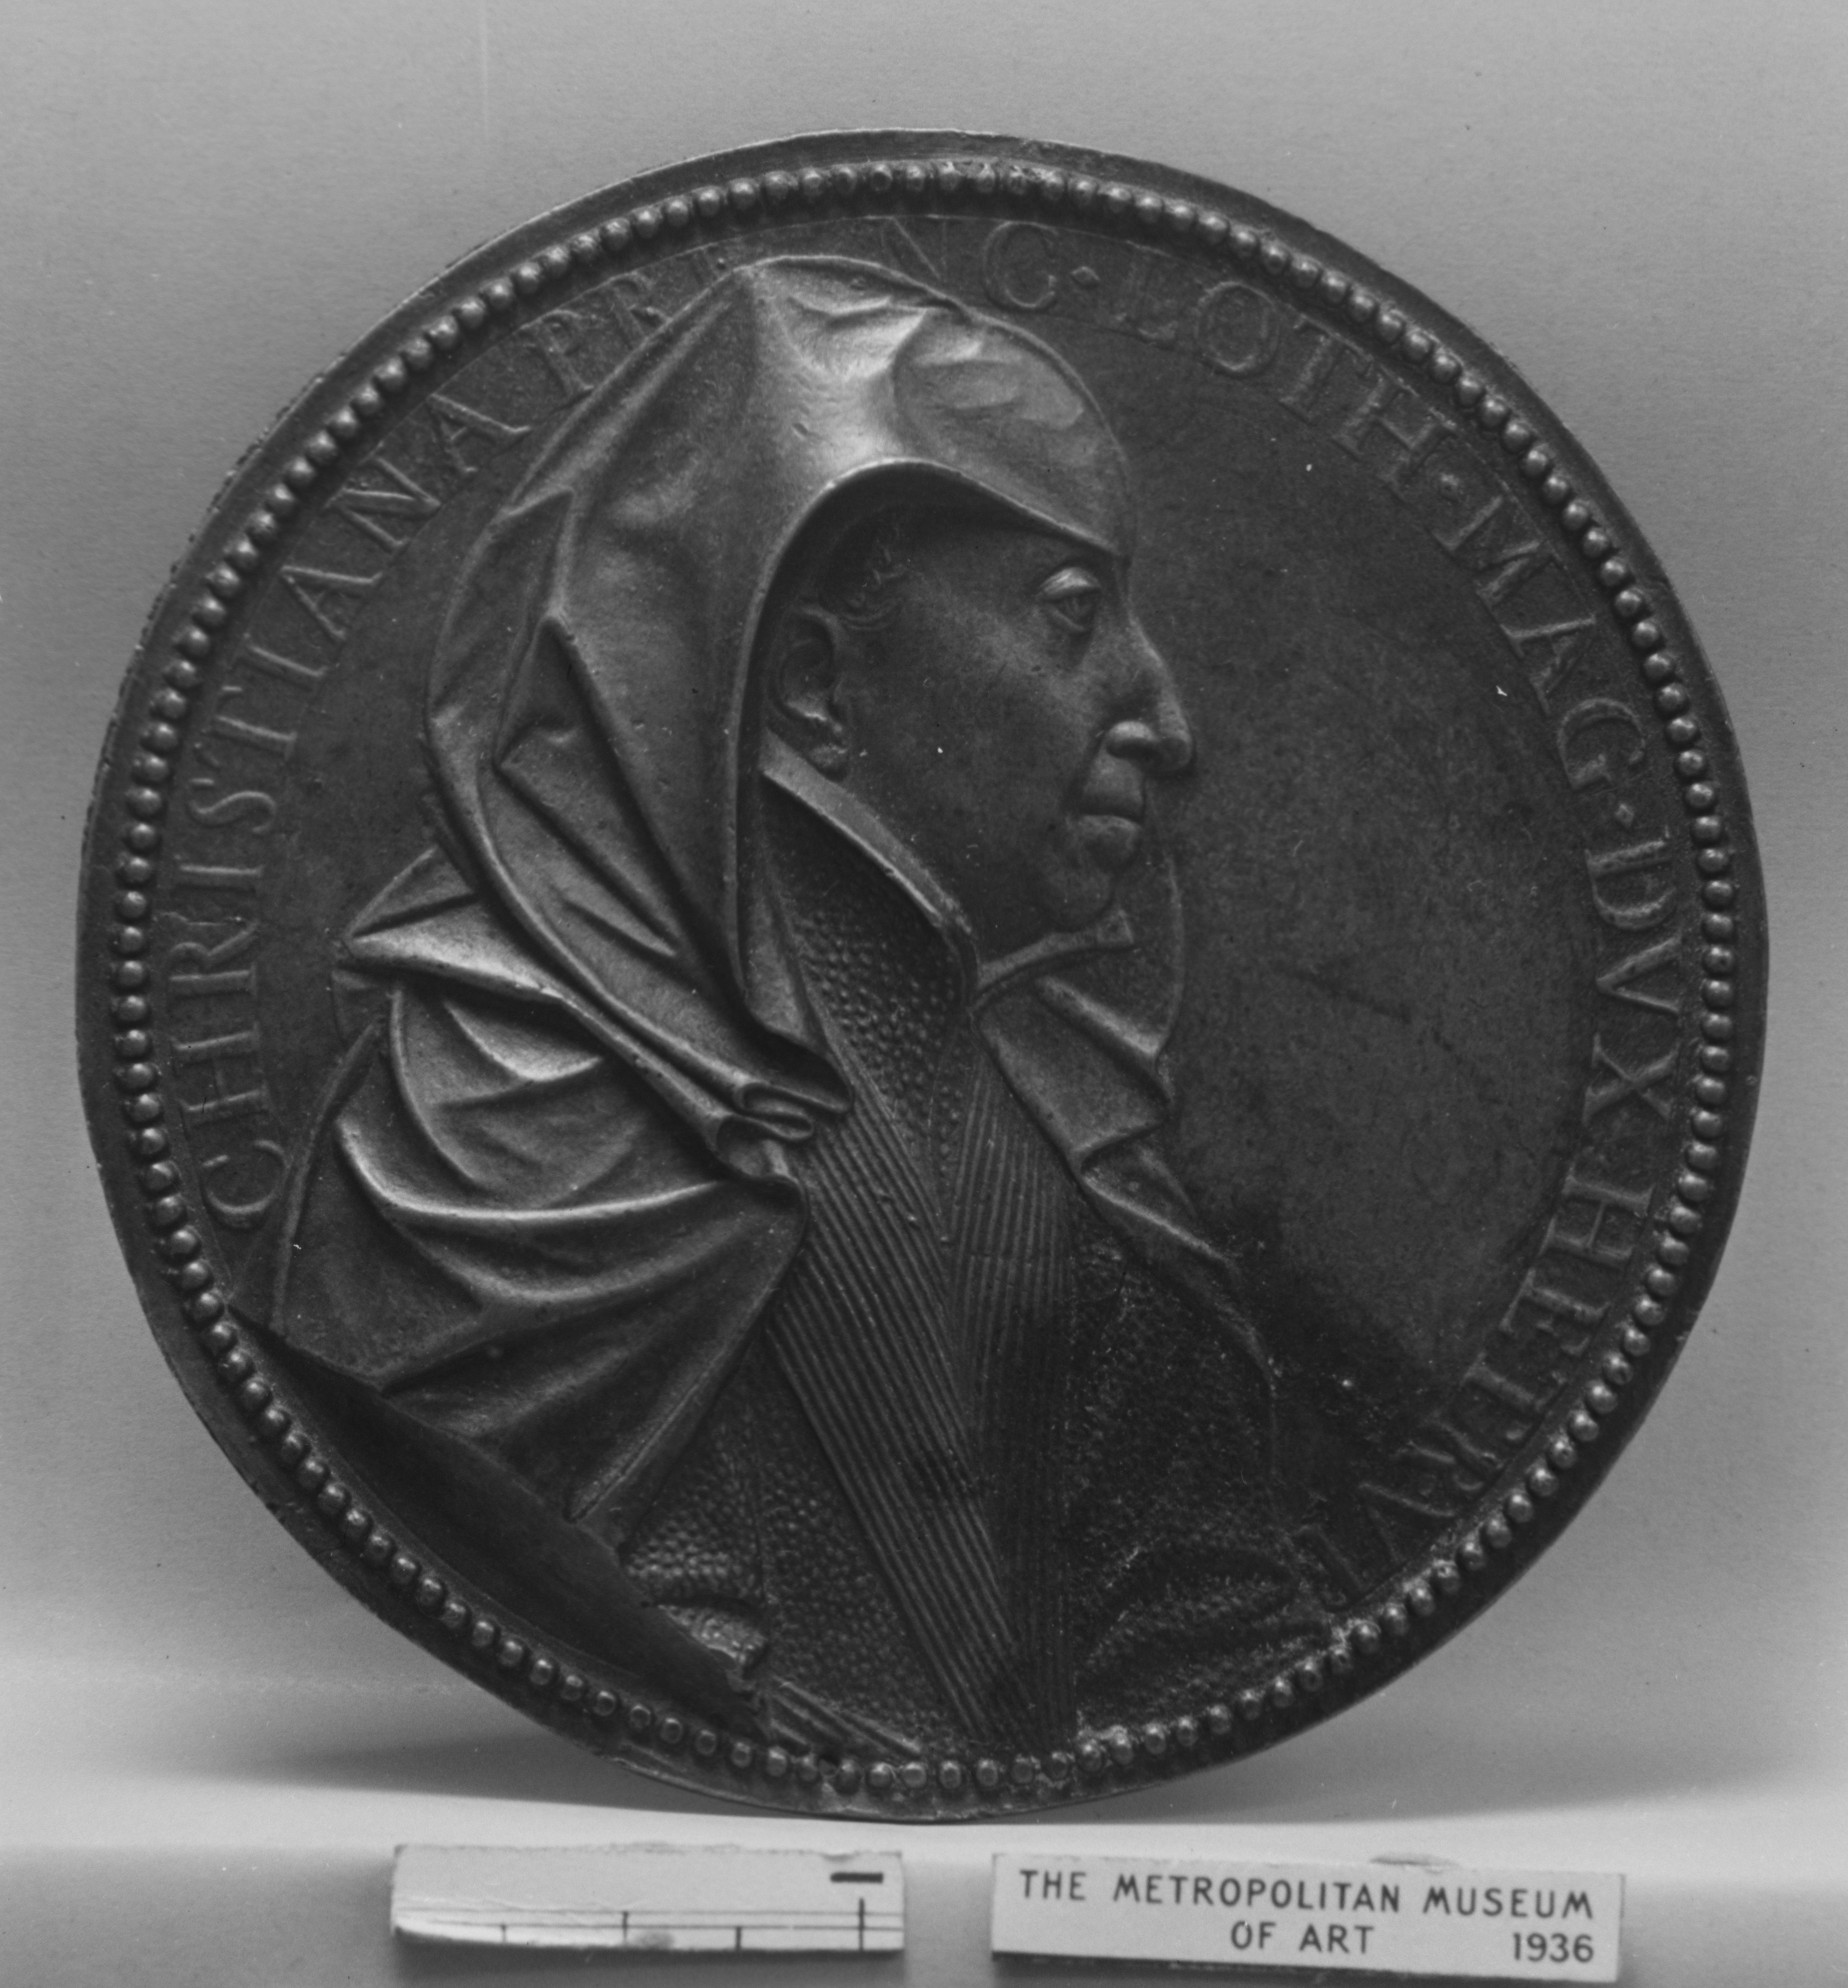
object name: medal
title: Christina of Lorraine (1565–1637), The Dowager Grand Duchess of Tuscany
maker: guillaume dupré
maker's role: artist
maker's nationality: french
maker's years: 1579-1640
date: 1613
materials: bronze, patina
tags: profiles,women